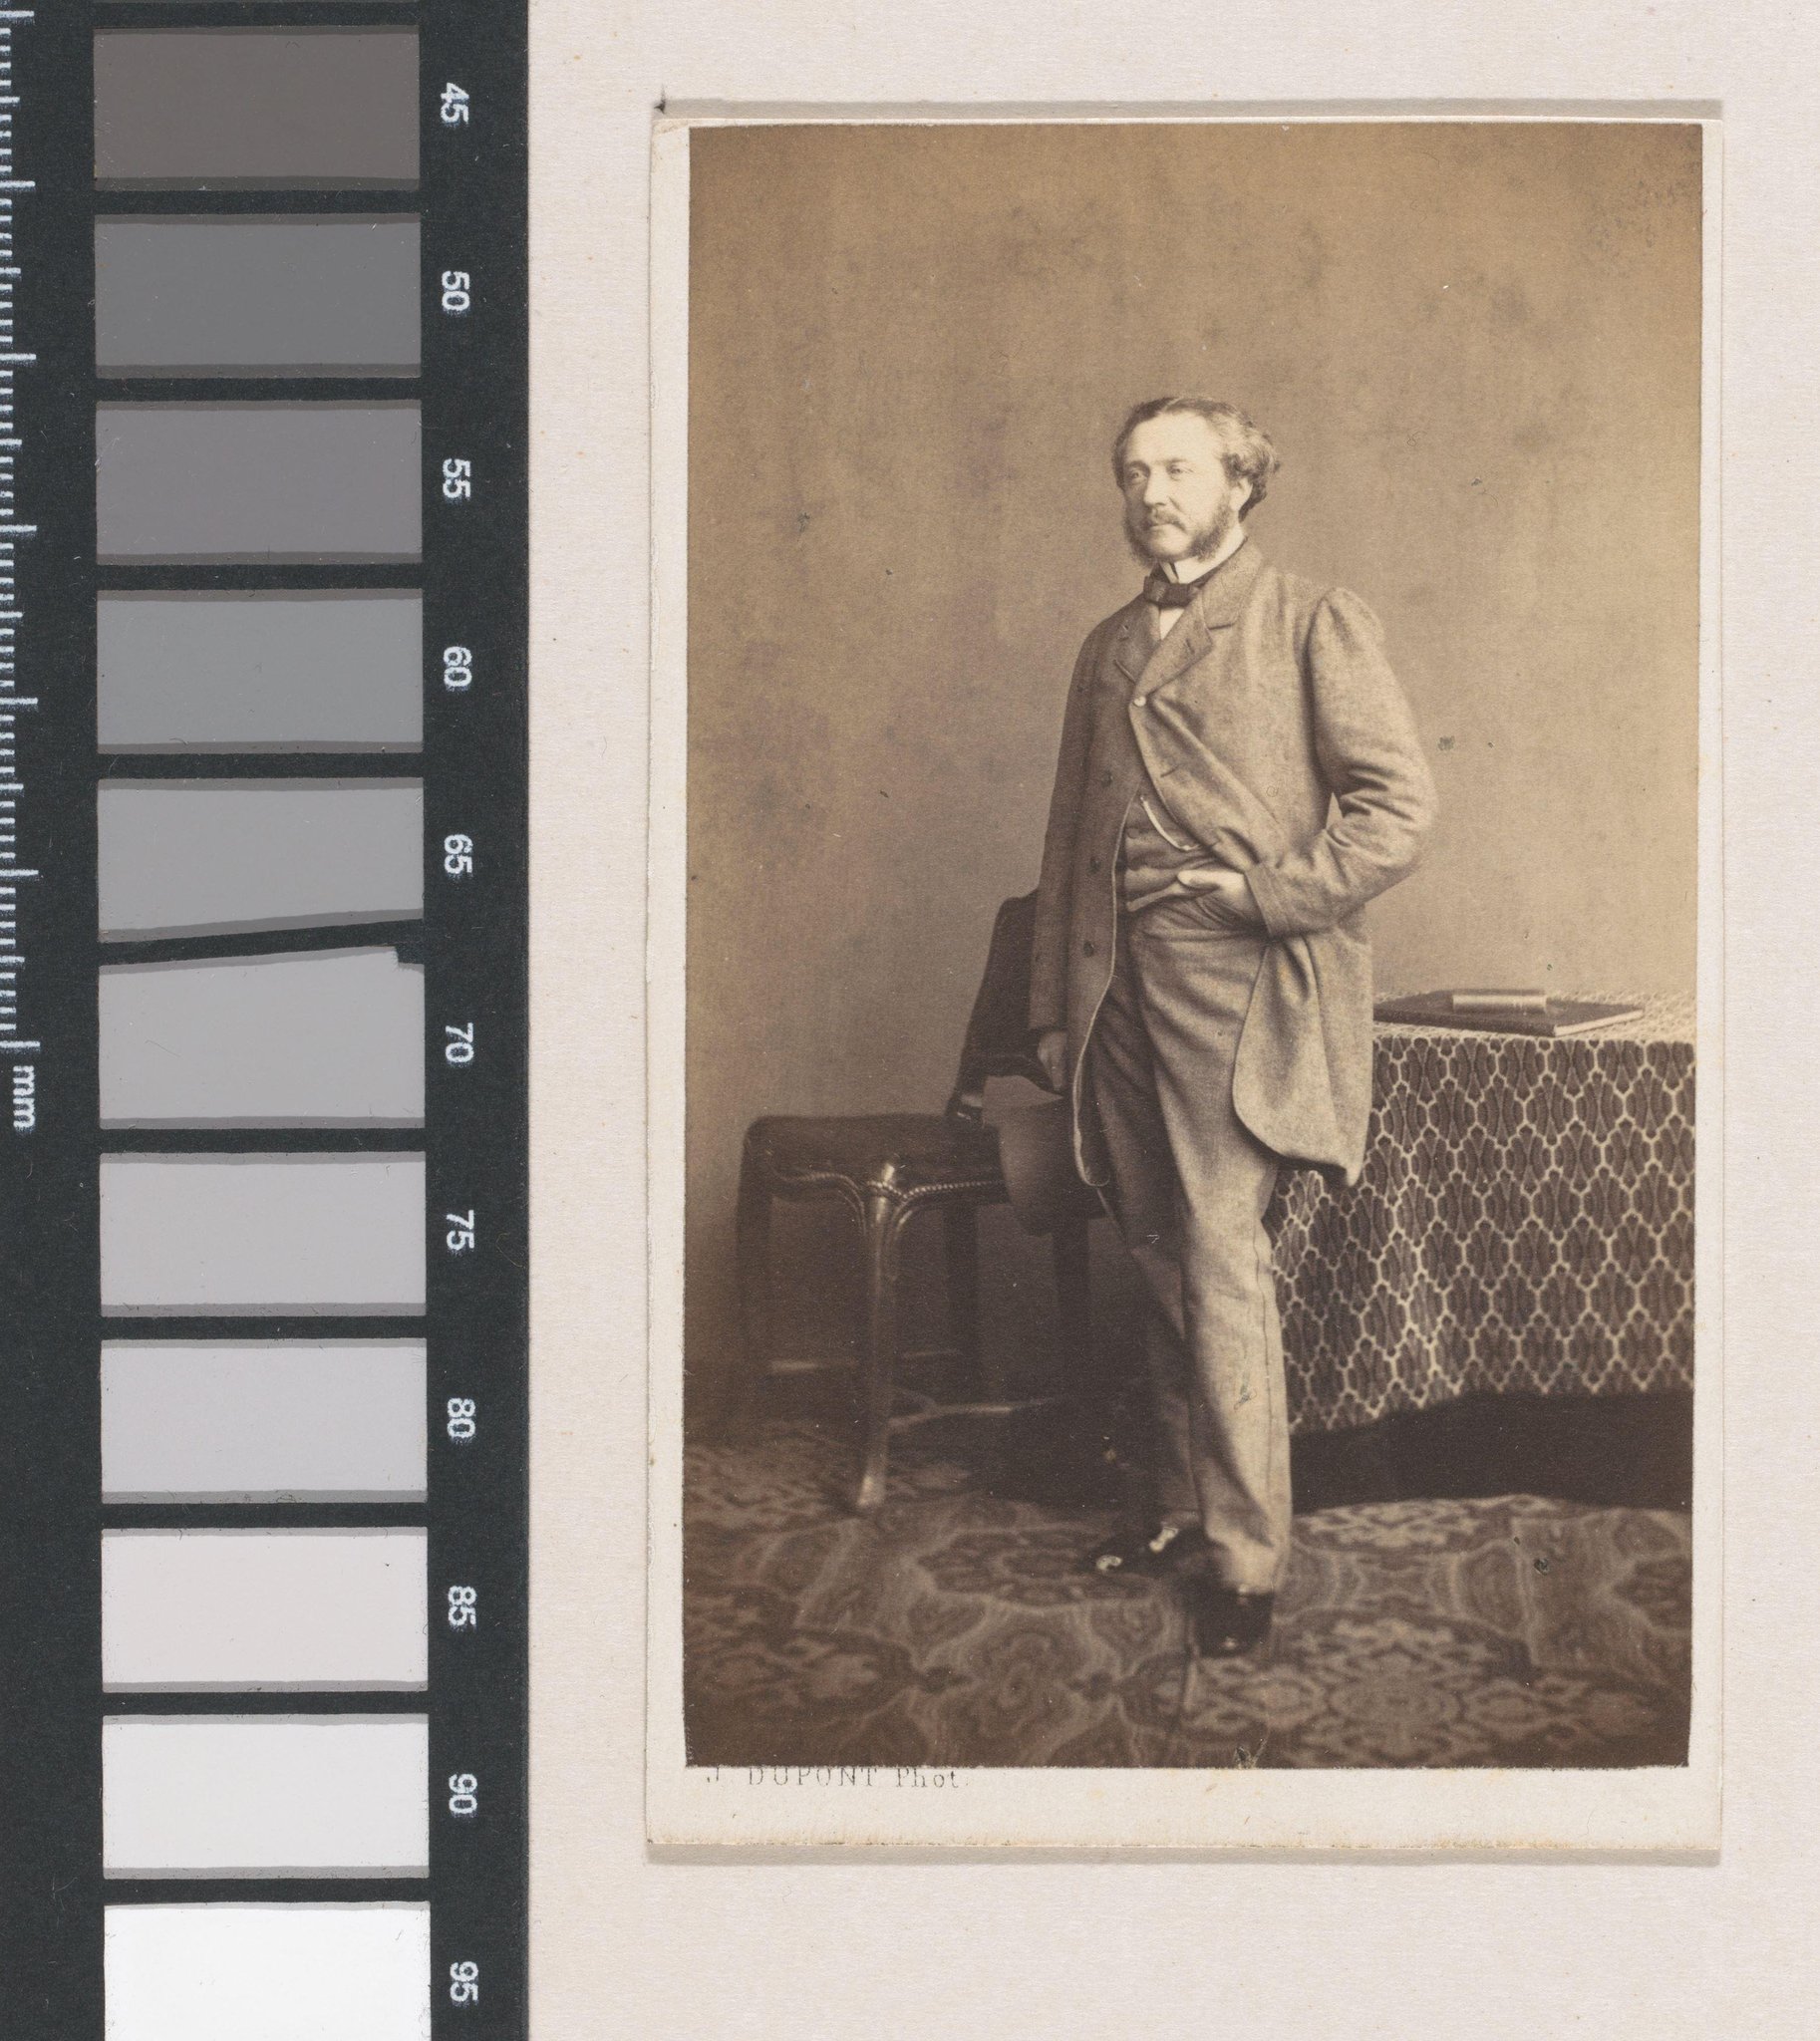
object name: carte de visite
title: L'École d'Anvers. Portraits biographies cartes de visite. Collection Dupont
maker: joseph dupont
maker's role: fotograaf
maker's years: 1818-1901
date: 1861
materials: cardboard, paper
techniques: albumen print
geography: antwerp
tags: historical persons, portrait, self-portrait of architect, portrait, self-portrait of artist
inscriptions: inscription: ‘ETABLISSEMENT PHOTOGRAPHIQUE/ de/ J. DUPONT/ Place de Meir 32/ ANVERS/ Maison fondée en 1853’